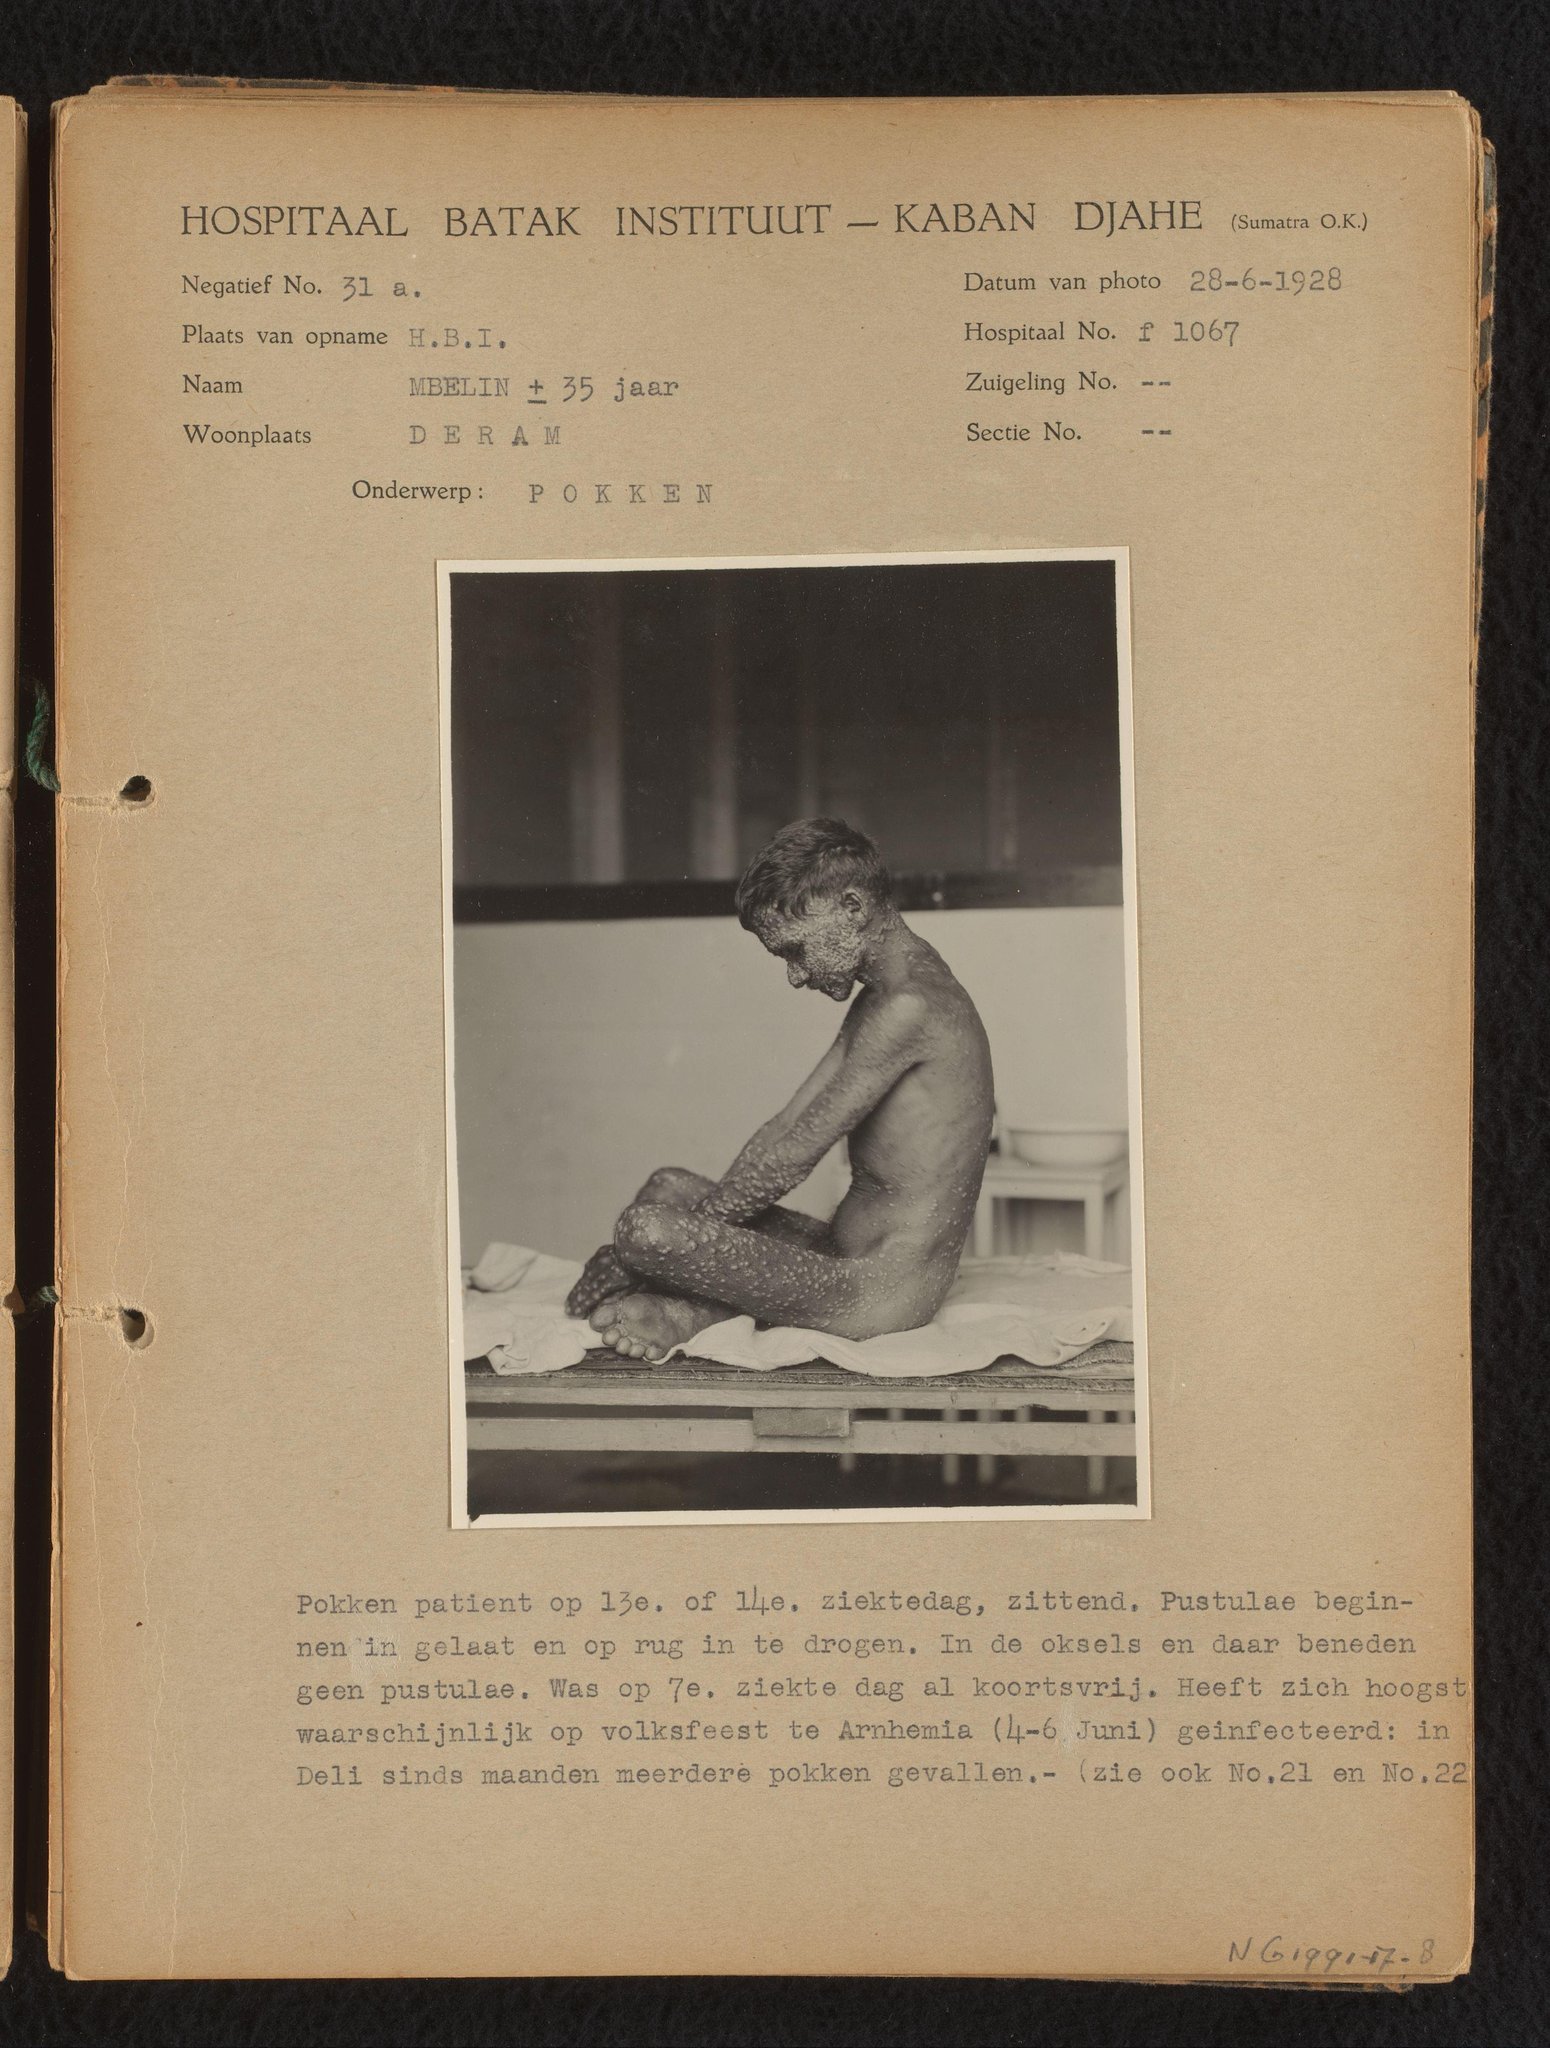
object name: photograph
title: Mannelijk patiënt met pokken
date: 1928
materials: cardboard, photographic support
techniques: gelatin silver print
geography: kabanjahe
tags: colonial system, patient, sick person, sumatra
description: Medische foto van een mannelijke patiënt genaamd Mbelin van ca. 35 jaar met pokken over het gehele lichaam. Datum foto: 28 juni 1928. Foto geplakt op voorgedrukt kartonnen blad ingebonden in het fotoalbum over het Hospitaal Batak Instituut te Kabanjaheh op Sumatra in de jaren 1926-1929.